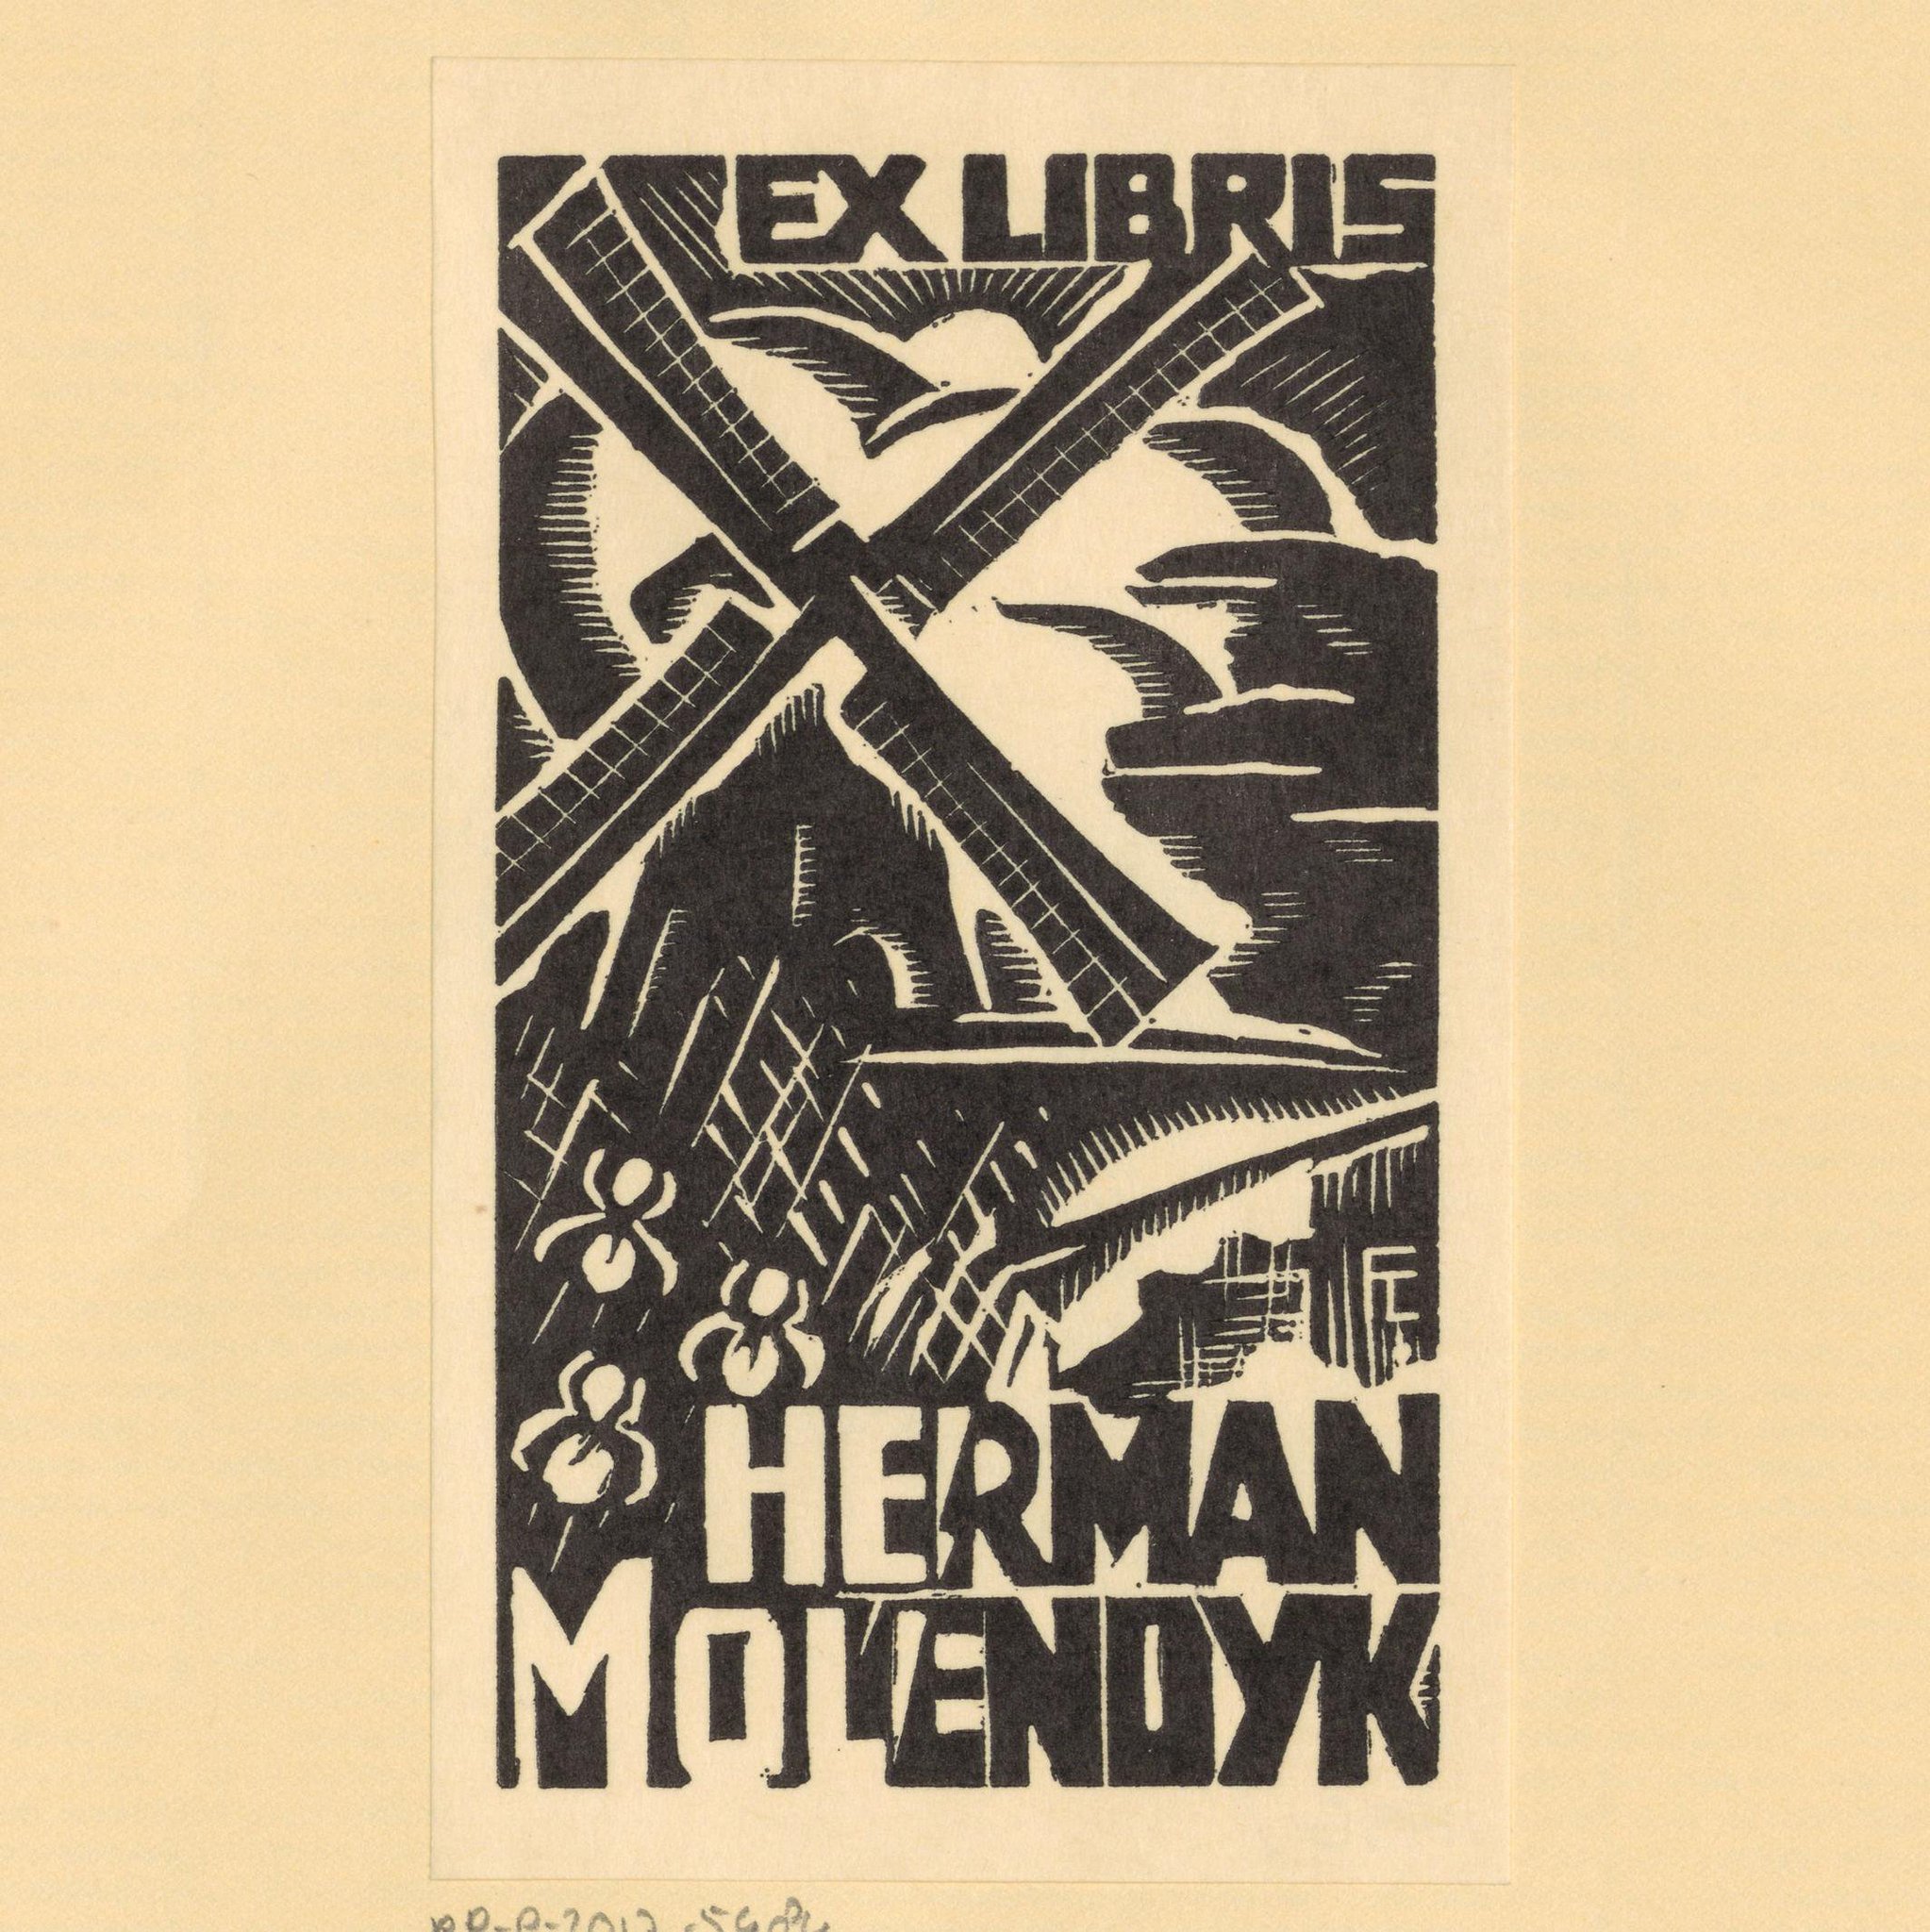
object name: bookplate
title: Ex libris van Herman Molendijk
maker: fré cohen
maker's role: draughtsman, print maker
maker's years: 1903-1943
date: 1936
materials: paper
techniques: woodcut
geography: netherlands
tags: flowers: iris, windmill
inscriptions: inscription: ‘1936’